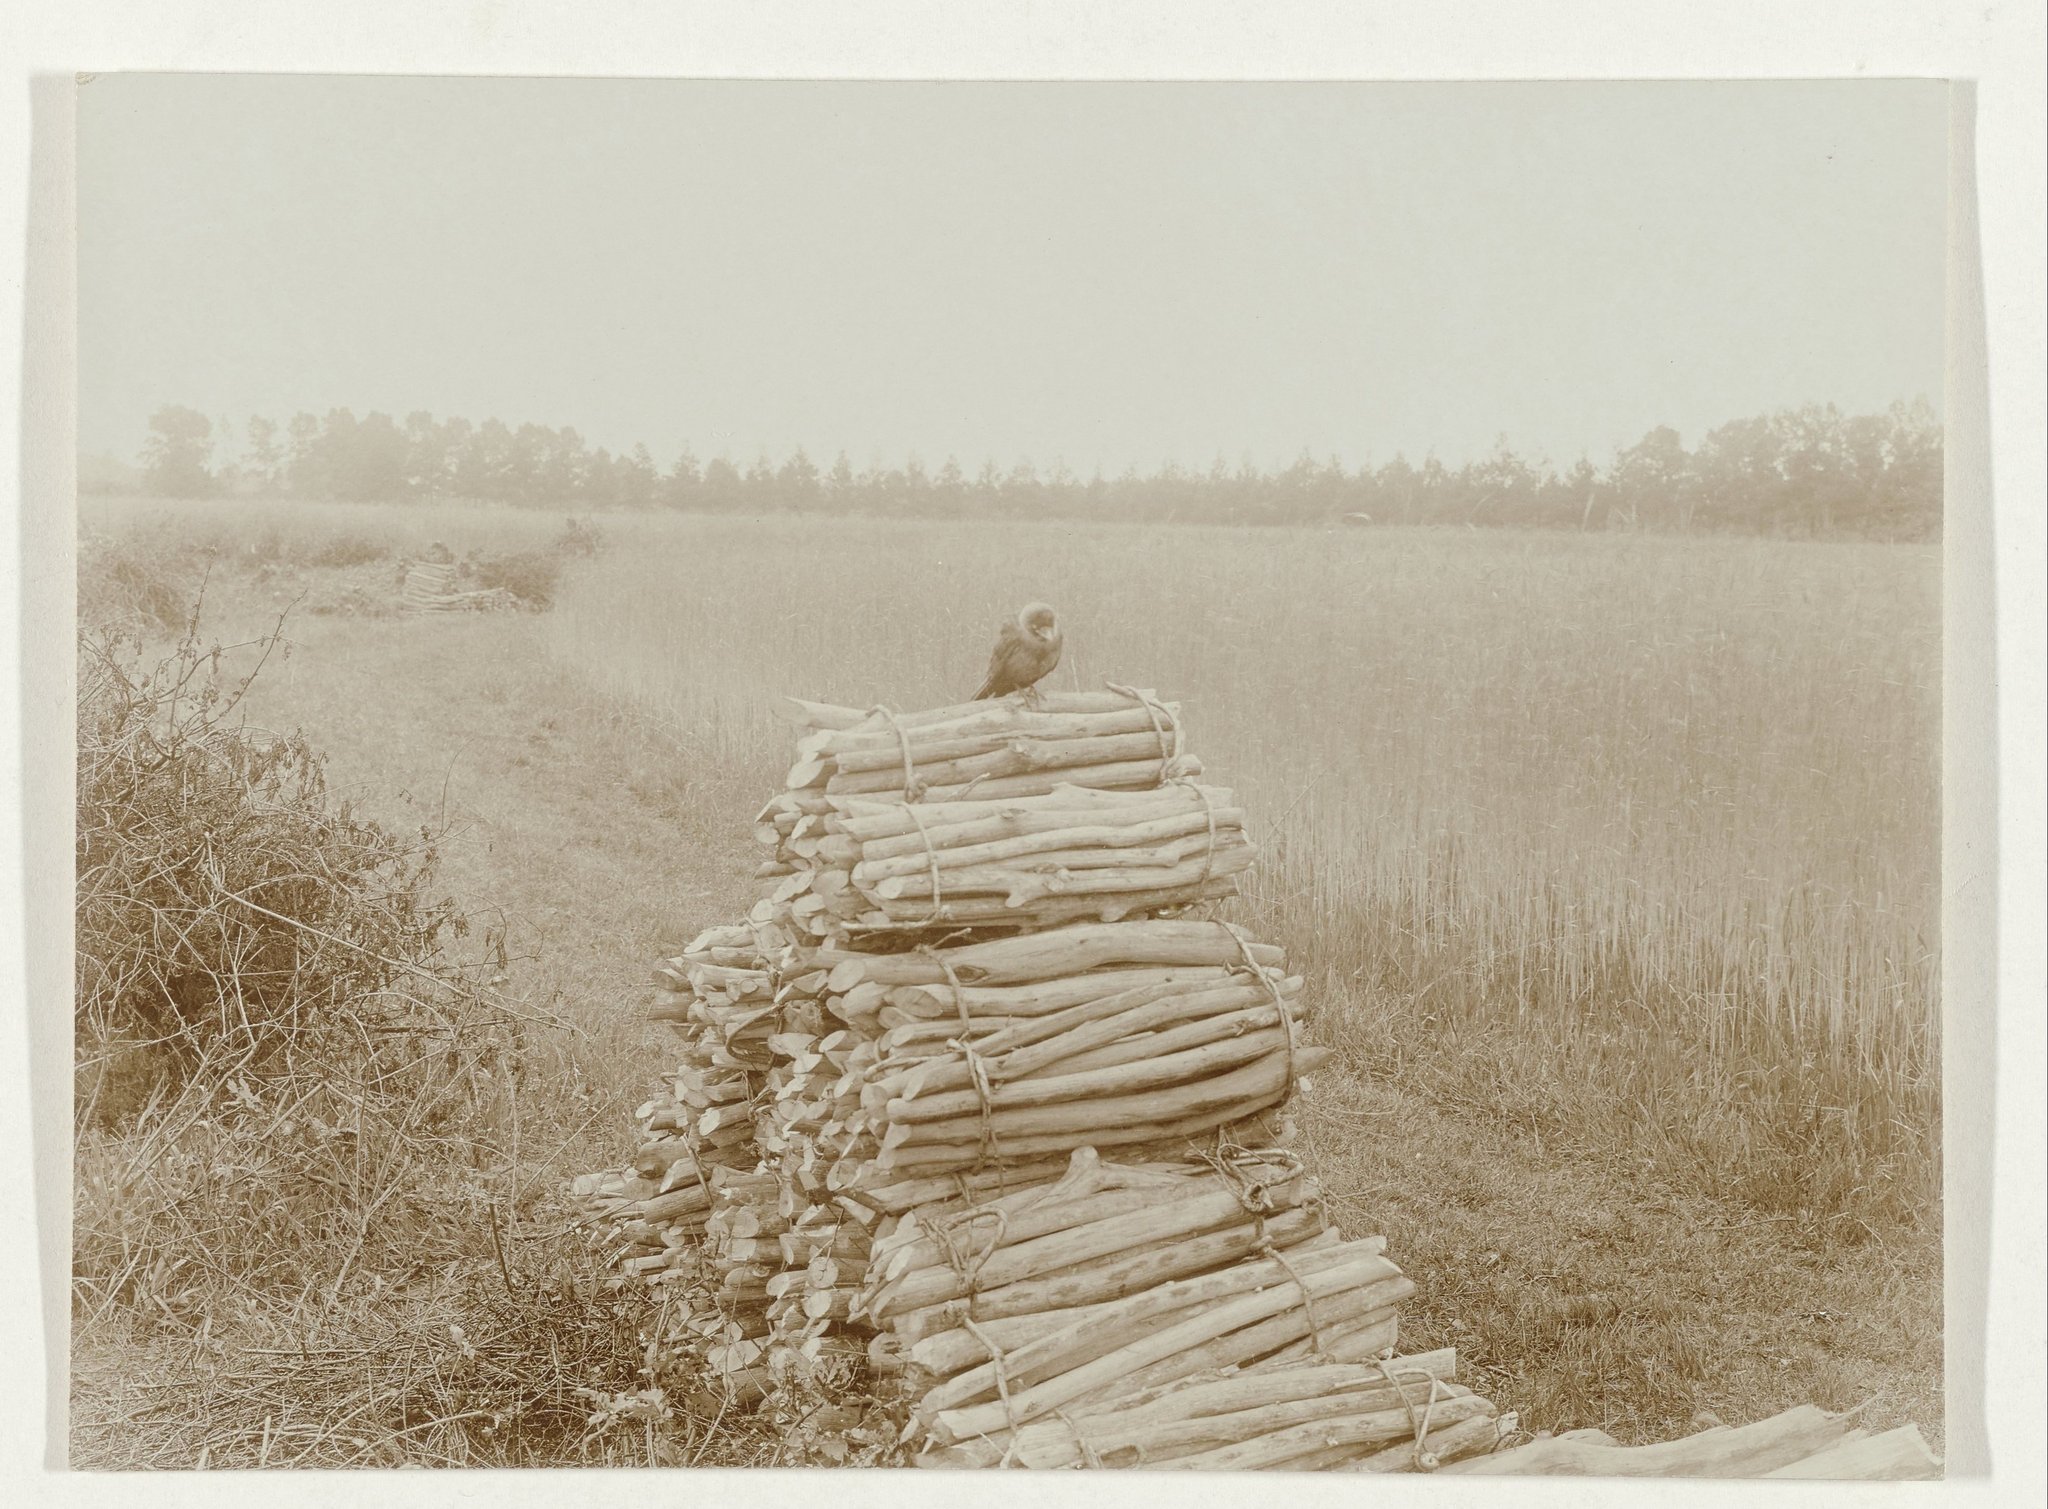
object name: photograph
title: Dohle sitzend auf einem Knüppelholzhaufen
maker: richard tepe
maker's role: fotograaf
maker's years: 1864-1952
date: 1900-1930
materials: paper, photographic support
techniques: collodion silver print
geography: netherlands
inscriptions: signature: ‘foto R. Tepe’, title: ‘Dohle sitzend auf einem Knüppelholzhaufen’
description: afgebeeld in Strijbos e.a. , Winter Een jaar natuurleven, pl. 34 (uitsnede) (Jantje, de kauw)